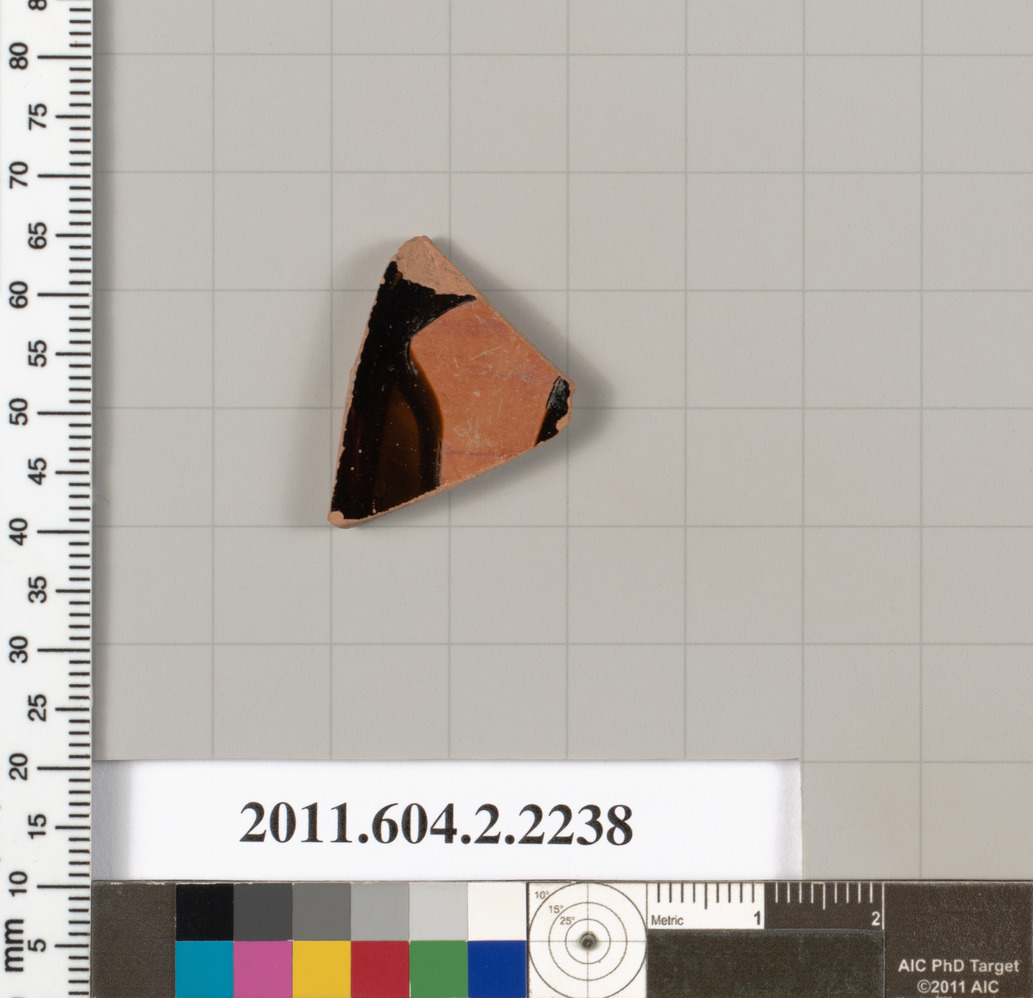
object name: pot fragment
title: Terracotta fragment of a pot; unglazed on the inside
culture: greek, attic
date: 460-440 BCE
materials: terracotta